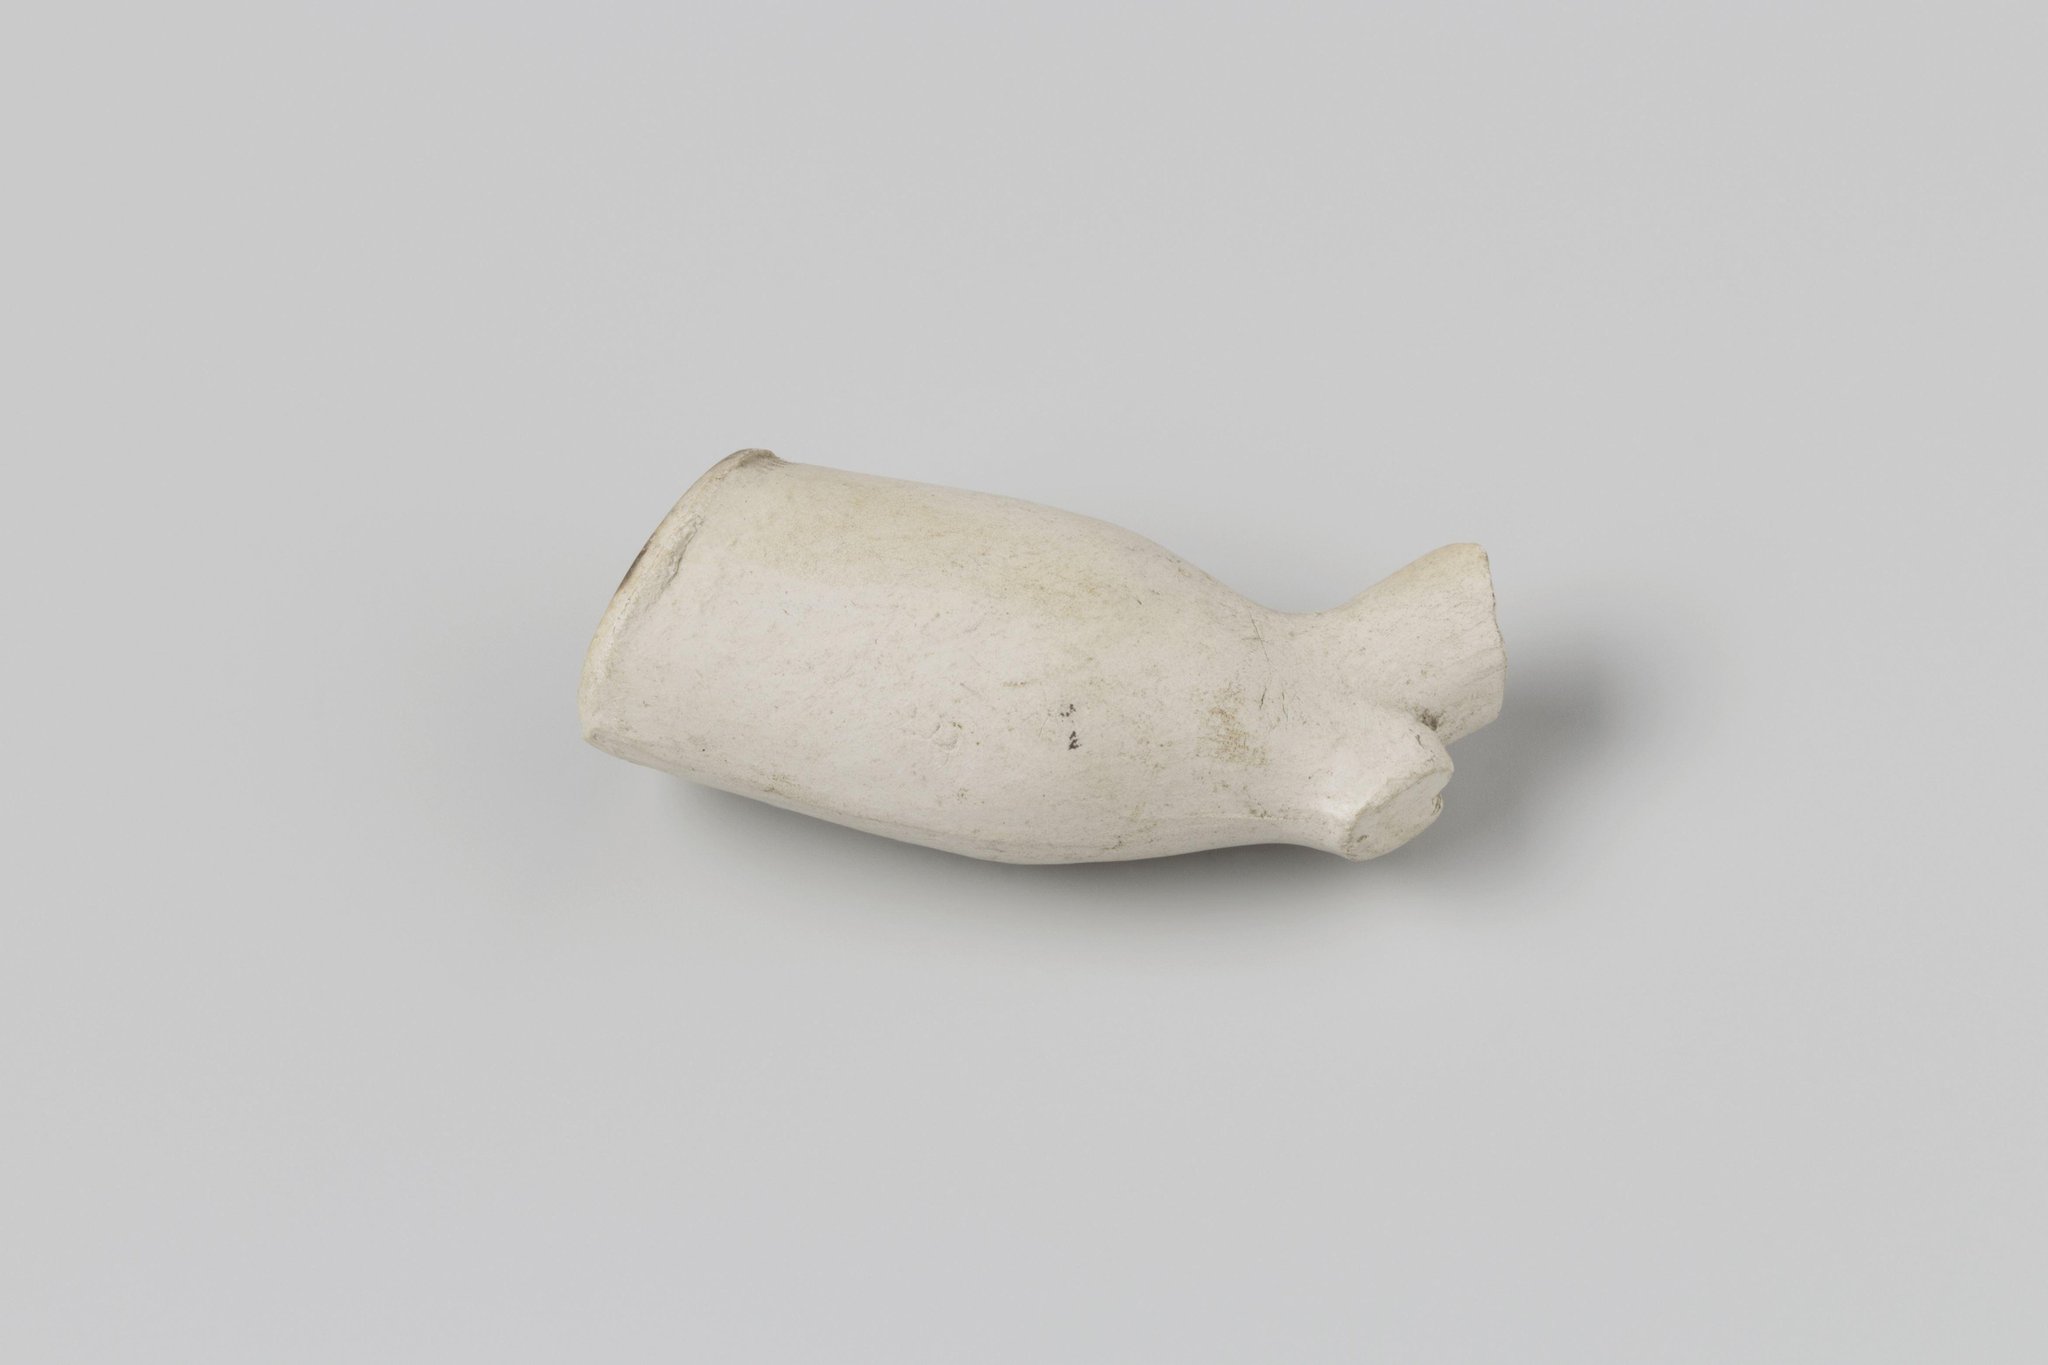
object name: pipe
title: Fragment van een tabakspijp.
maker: Anonymous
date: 1400-1950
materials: earthenware, clay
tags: loevestein castle